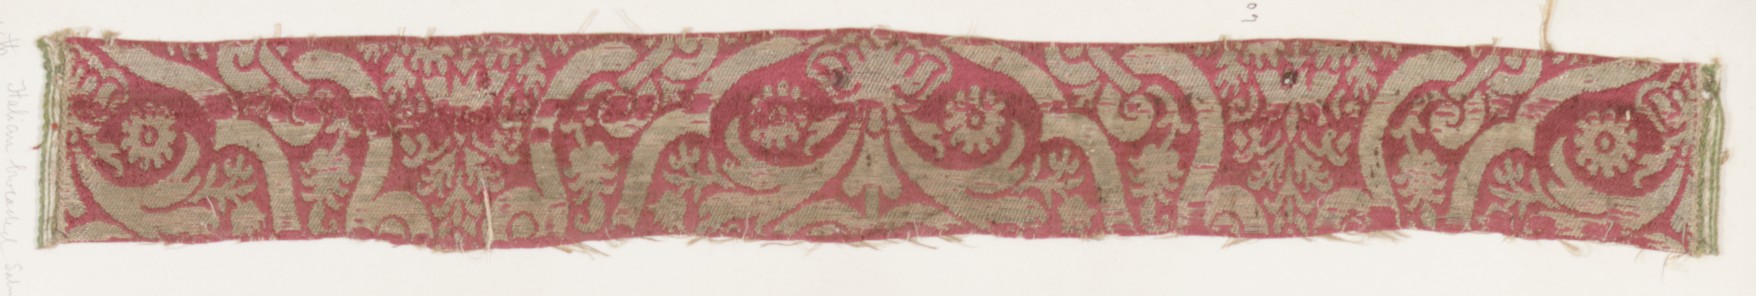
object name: fragment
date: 1501-1600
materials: metal thread, silk